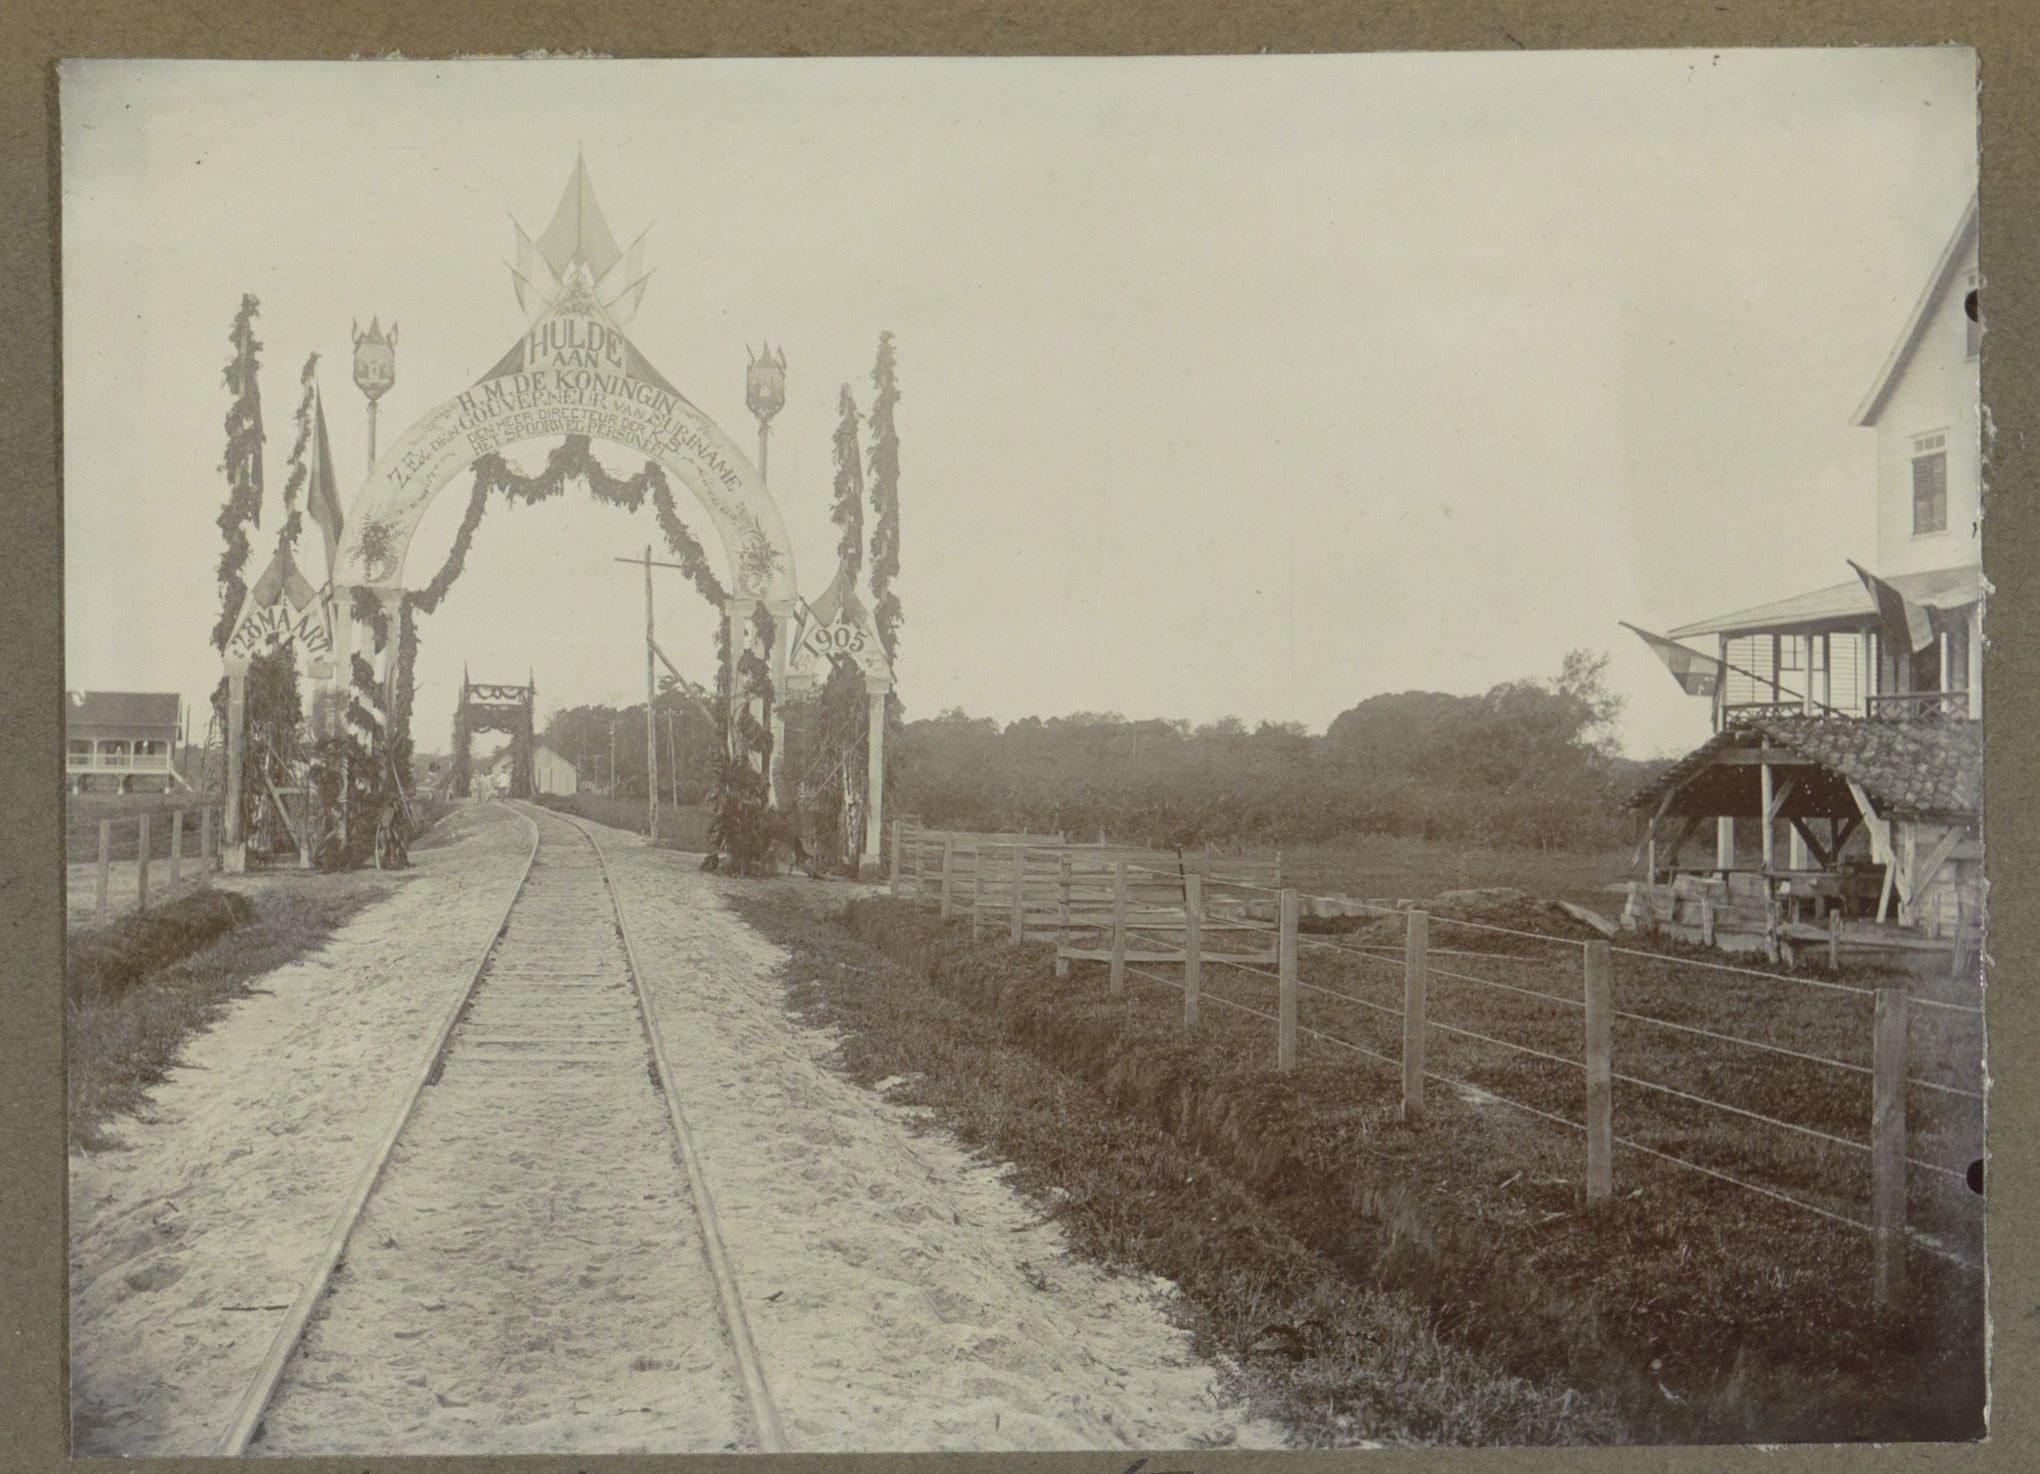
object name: photograph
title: Erepoort in Paramaribo, opgericht ter gelegenheid van de opening van de Lawaspoorlijn (Landsspoorweg) op 28 maart 1905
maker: eugen klein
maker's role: fotograaf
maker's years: 1869-1927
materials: photographic support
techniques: gelatin silver print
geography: paramaribo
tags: gate, entrance, railway, train, festivities on events of national importance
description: Onderdeel van fotoalbum van een onbekende Nederlandse familie met opnames van Suriname, Europa en Nederlands-Indië.